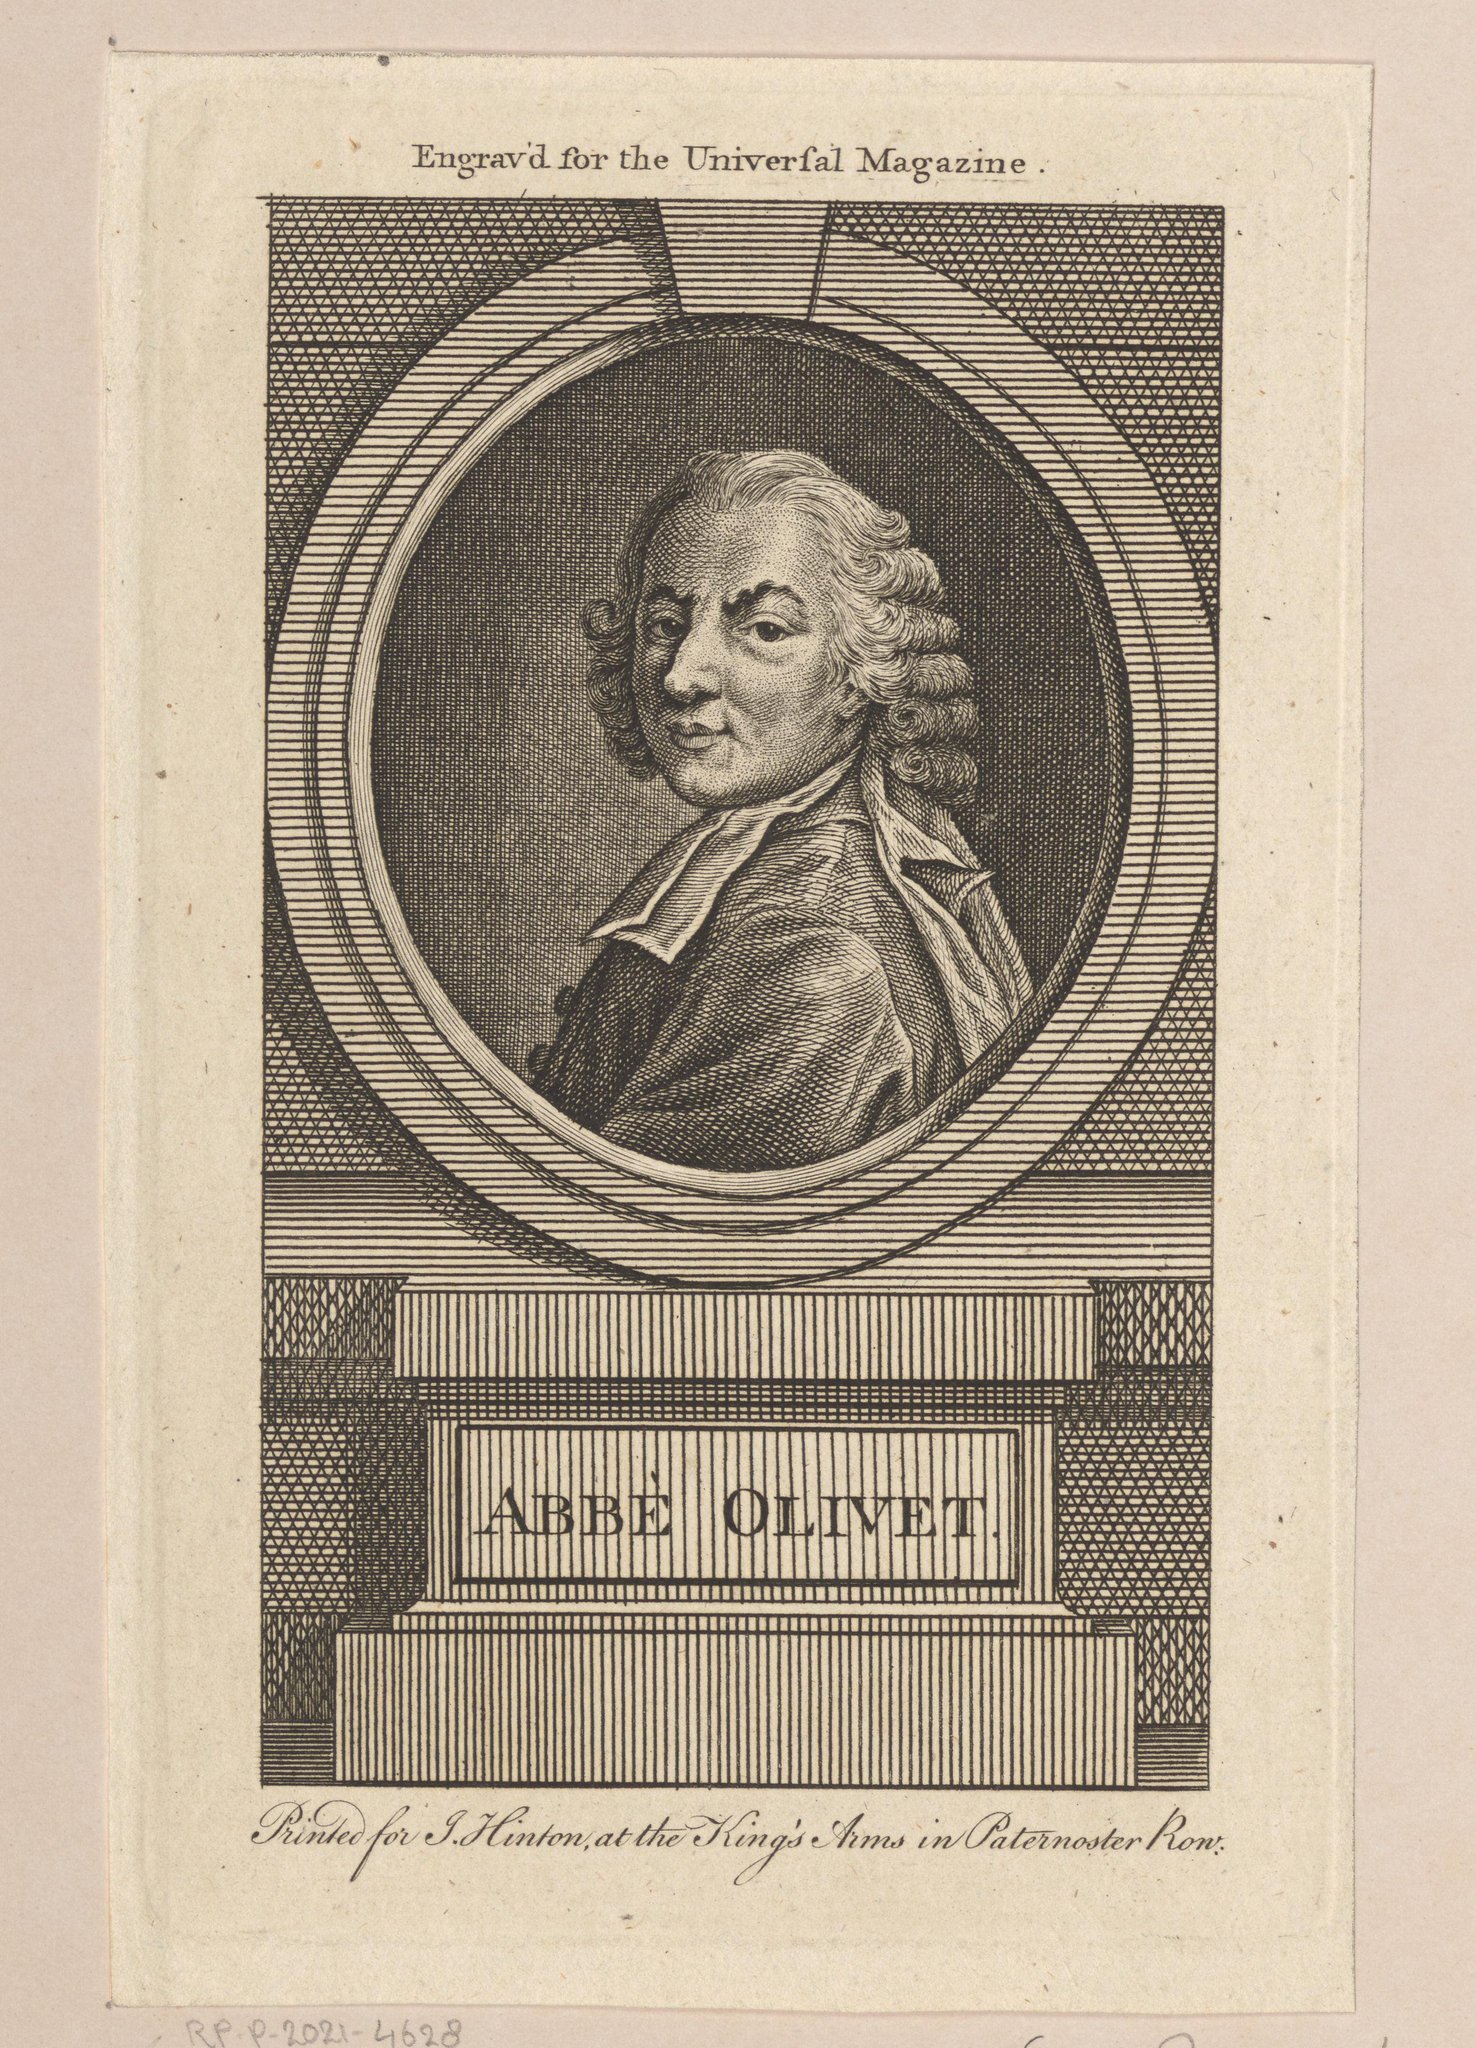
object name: print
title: Portret van Pierre-Joseph Thoulier d'Olivet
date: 1747-1781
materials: paper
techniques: engraving, etching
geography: london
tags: paris, historical persons, writer, poet, author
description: Prent uit: Universal Magazine, uitgegeven tussen 1747-1814.